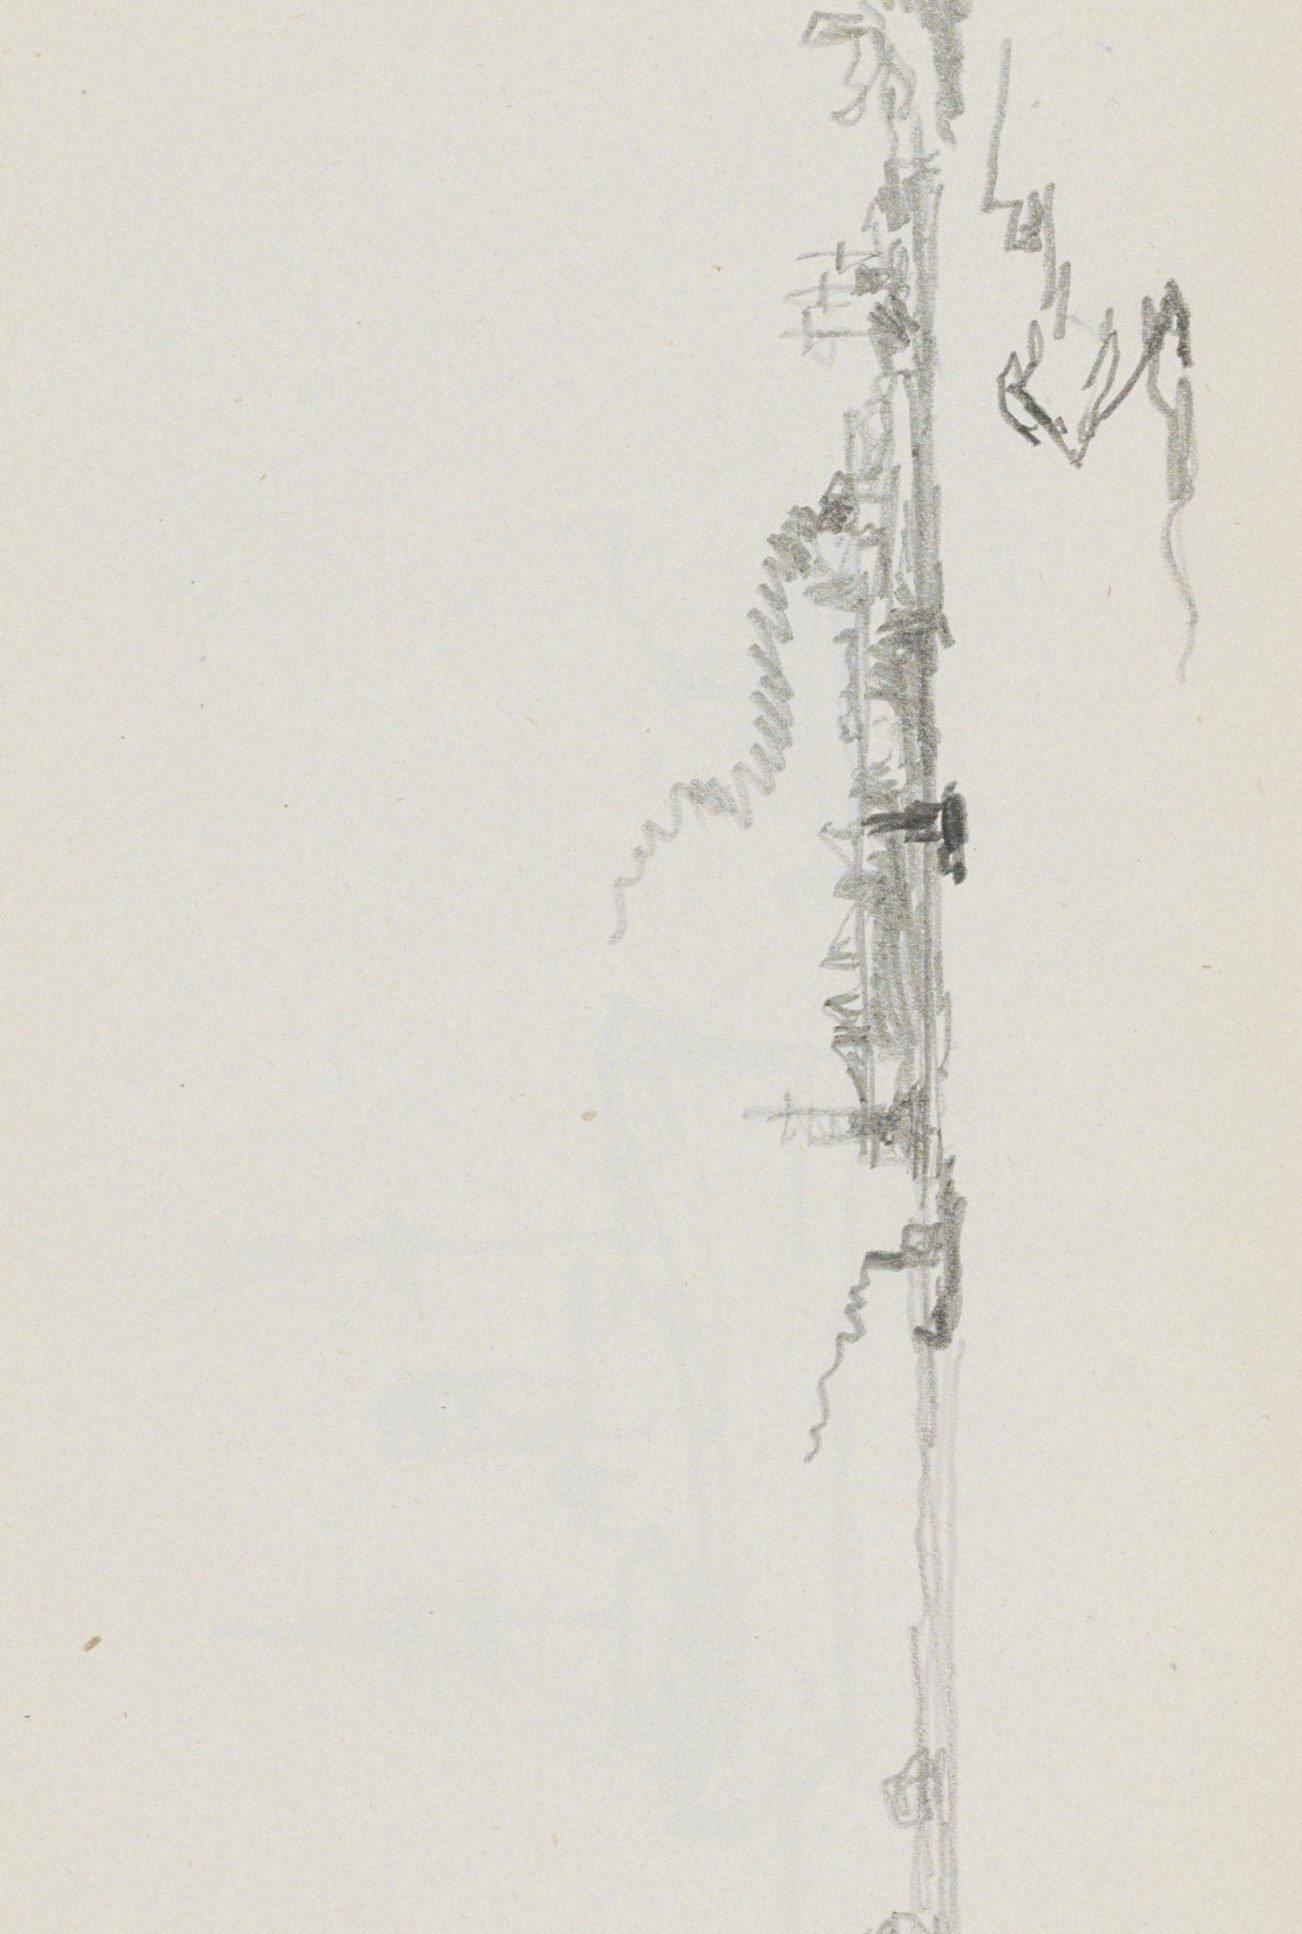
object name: sketchbook leaf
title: Havengezicht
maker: cornelis vreedenburgh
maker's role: draughtsman, print maker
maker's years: 1880-1946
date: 1890-1946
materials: paper, pencil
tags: harbour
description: Blad 48 recto uit een schetsboek met uit 75 bladen.